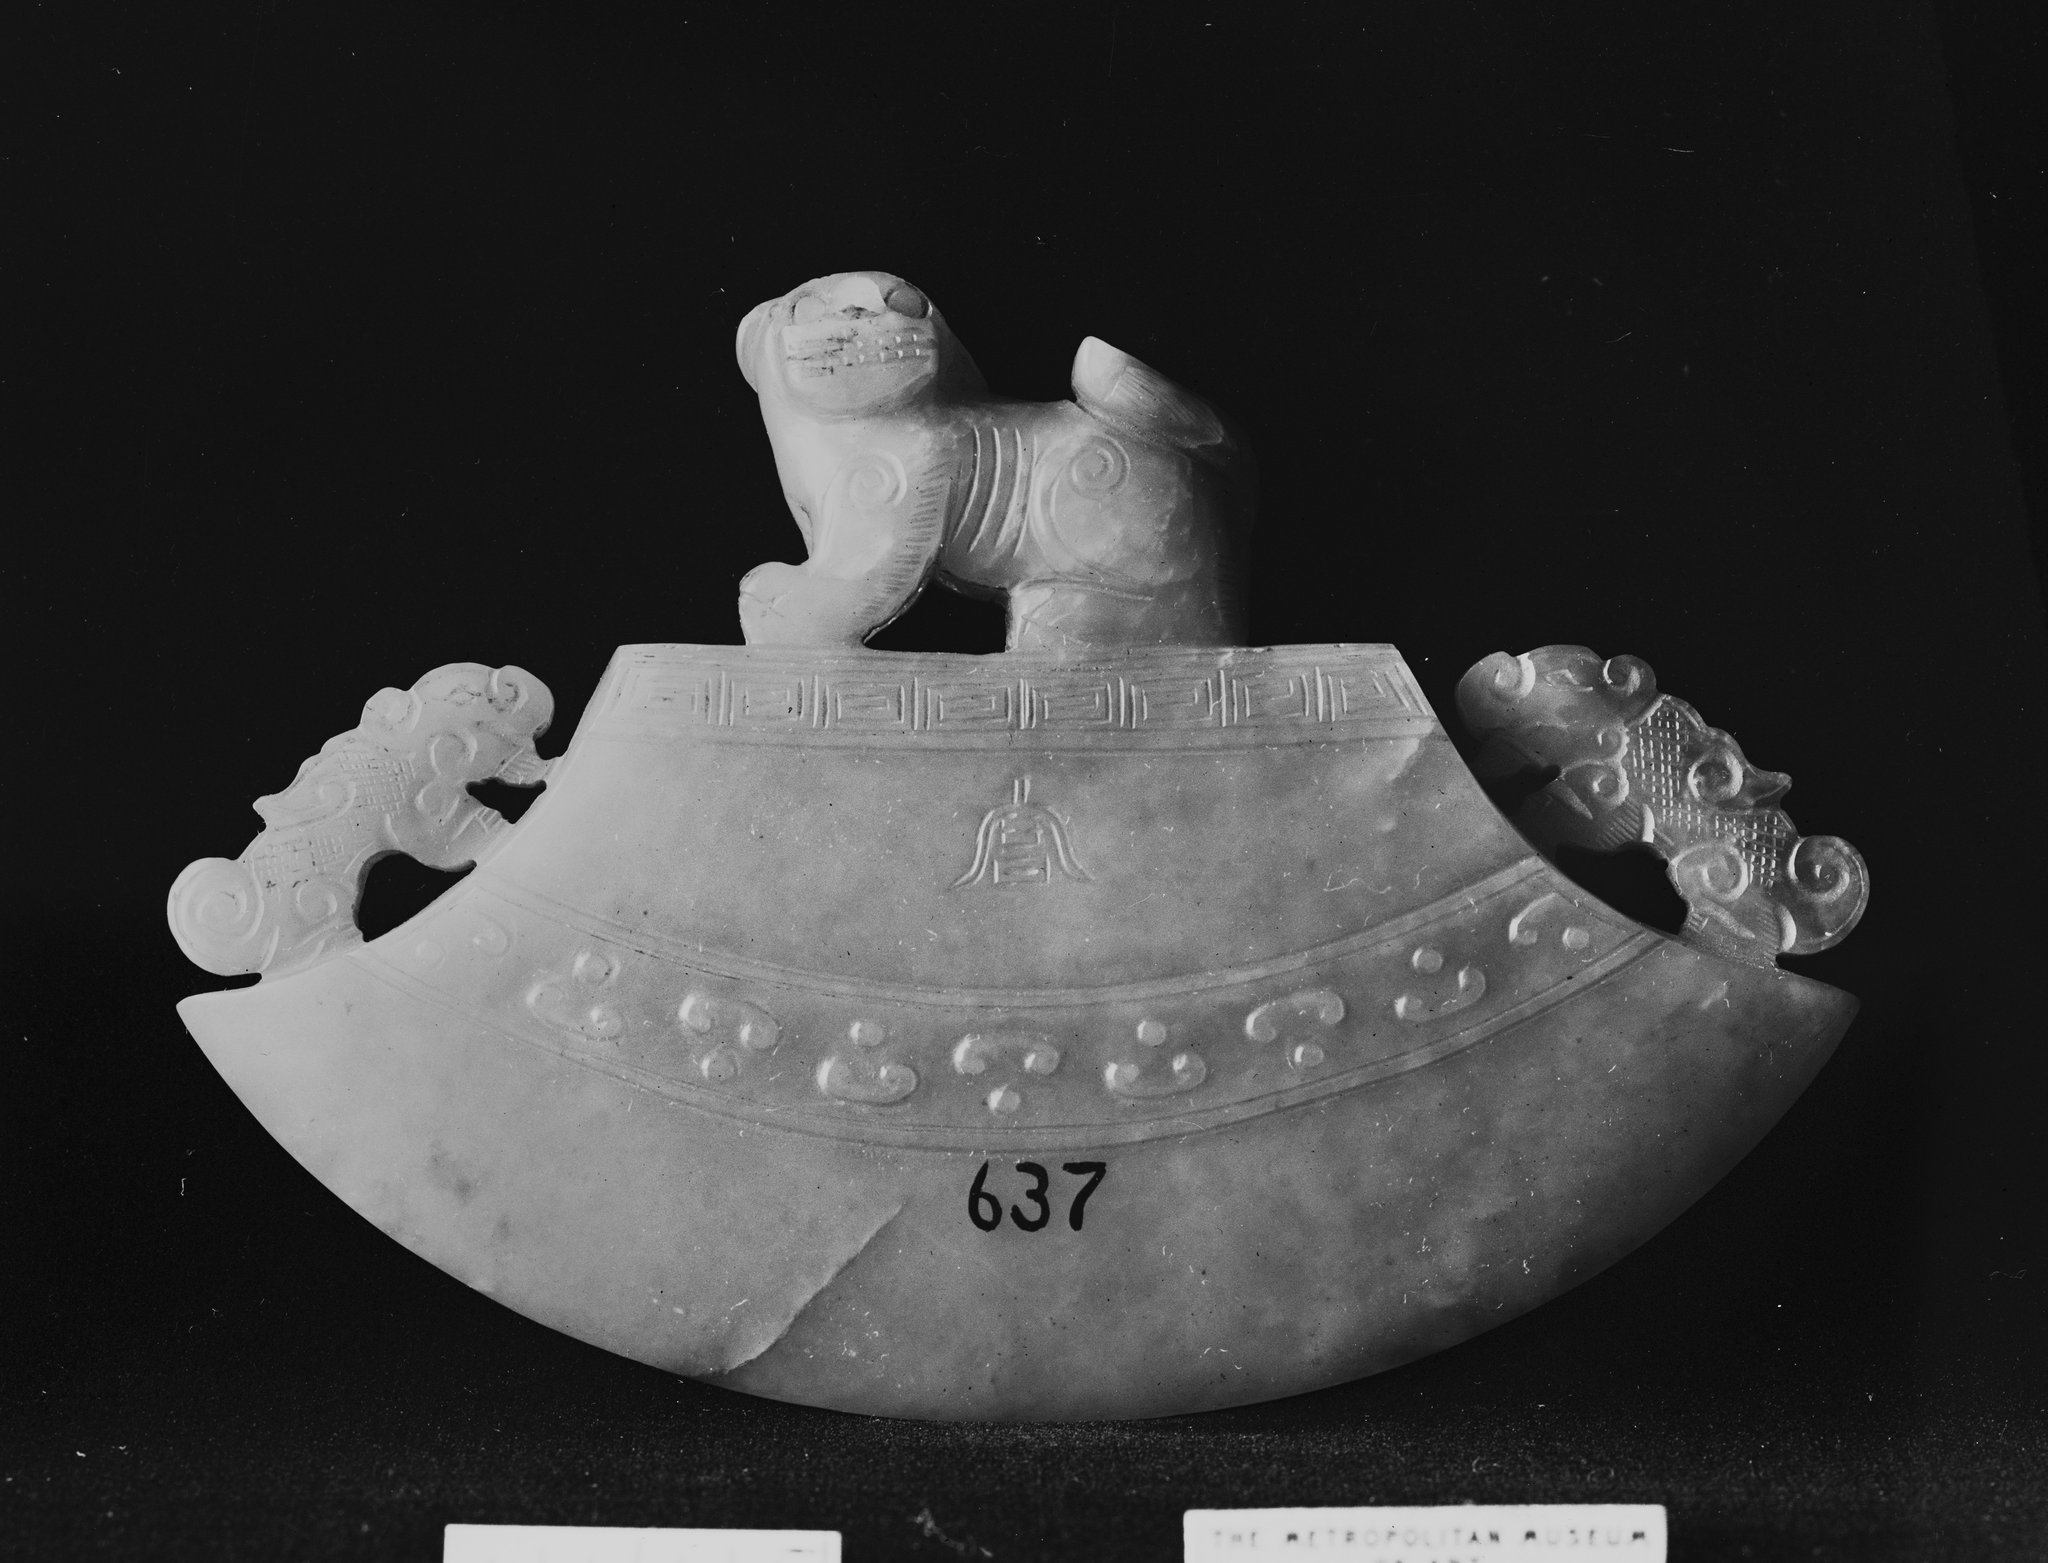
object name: axe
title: Ceremonial Axe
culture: chinese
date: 1736-1795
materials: jade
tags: animals,axes